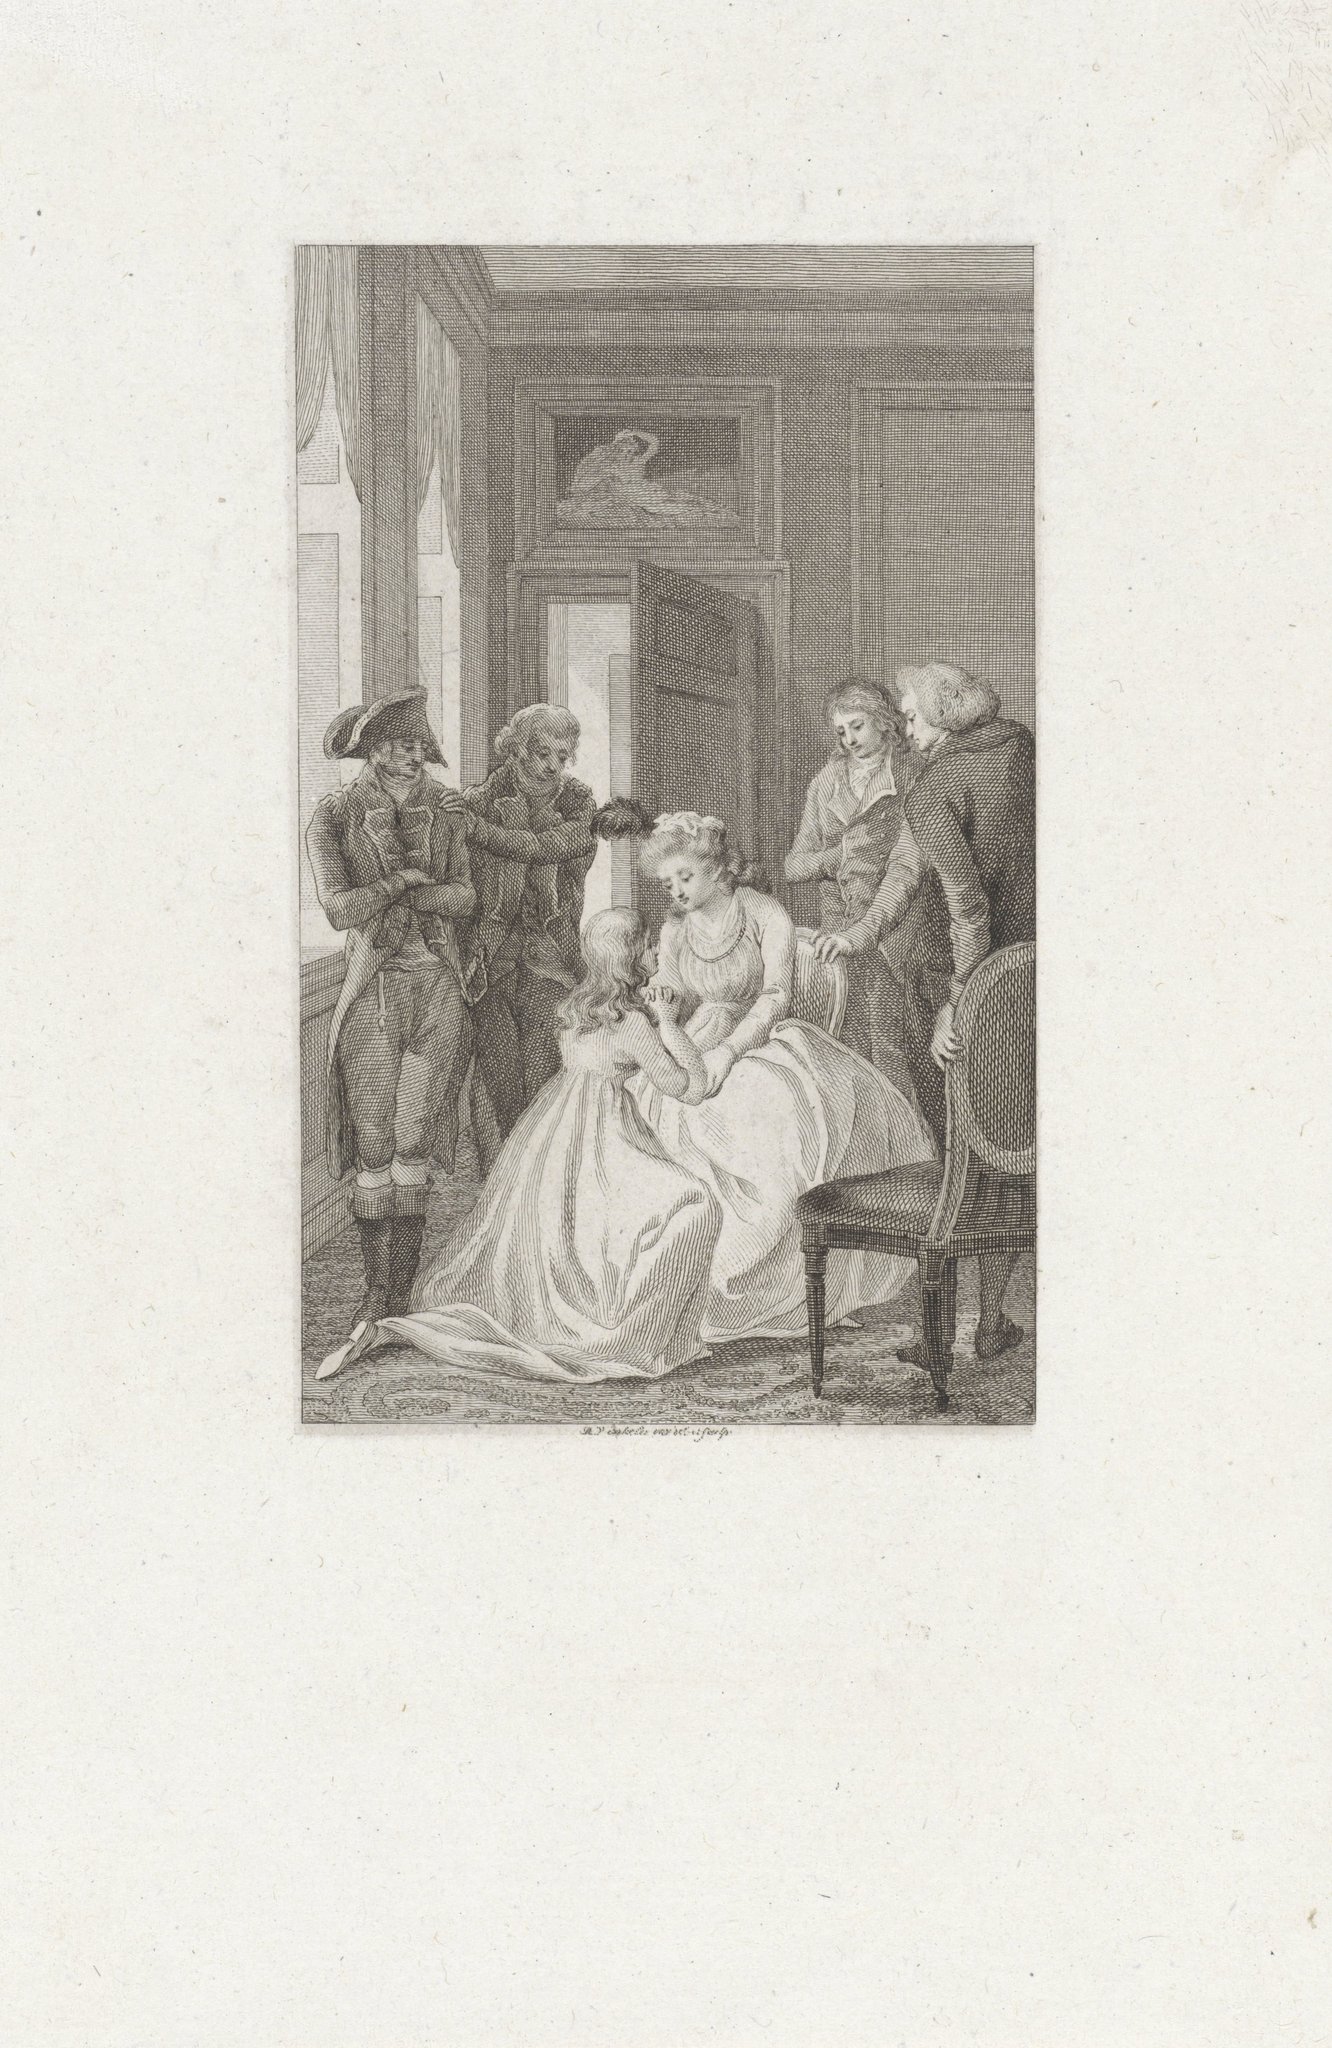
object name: print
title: Jonge vrouw knielt voor haar moeder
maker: reinier vinkeles (i)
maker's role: draughtsman, print maker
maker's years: 1741-1816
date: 1799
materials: paper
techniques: engraving, etching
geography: amsterdam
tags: mother and daughter(s) (family group), kneeling figure, picture, painting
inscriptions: collector's mark: Lugt 240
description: Omringd door verschillende mannen, zit een jonge vrouw met ineengevouwen handen in geknielde houding voor haar zittende moeder.